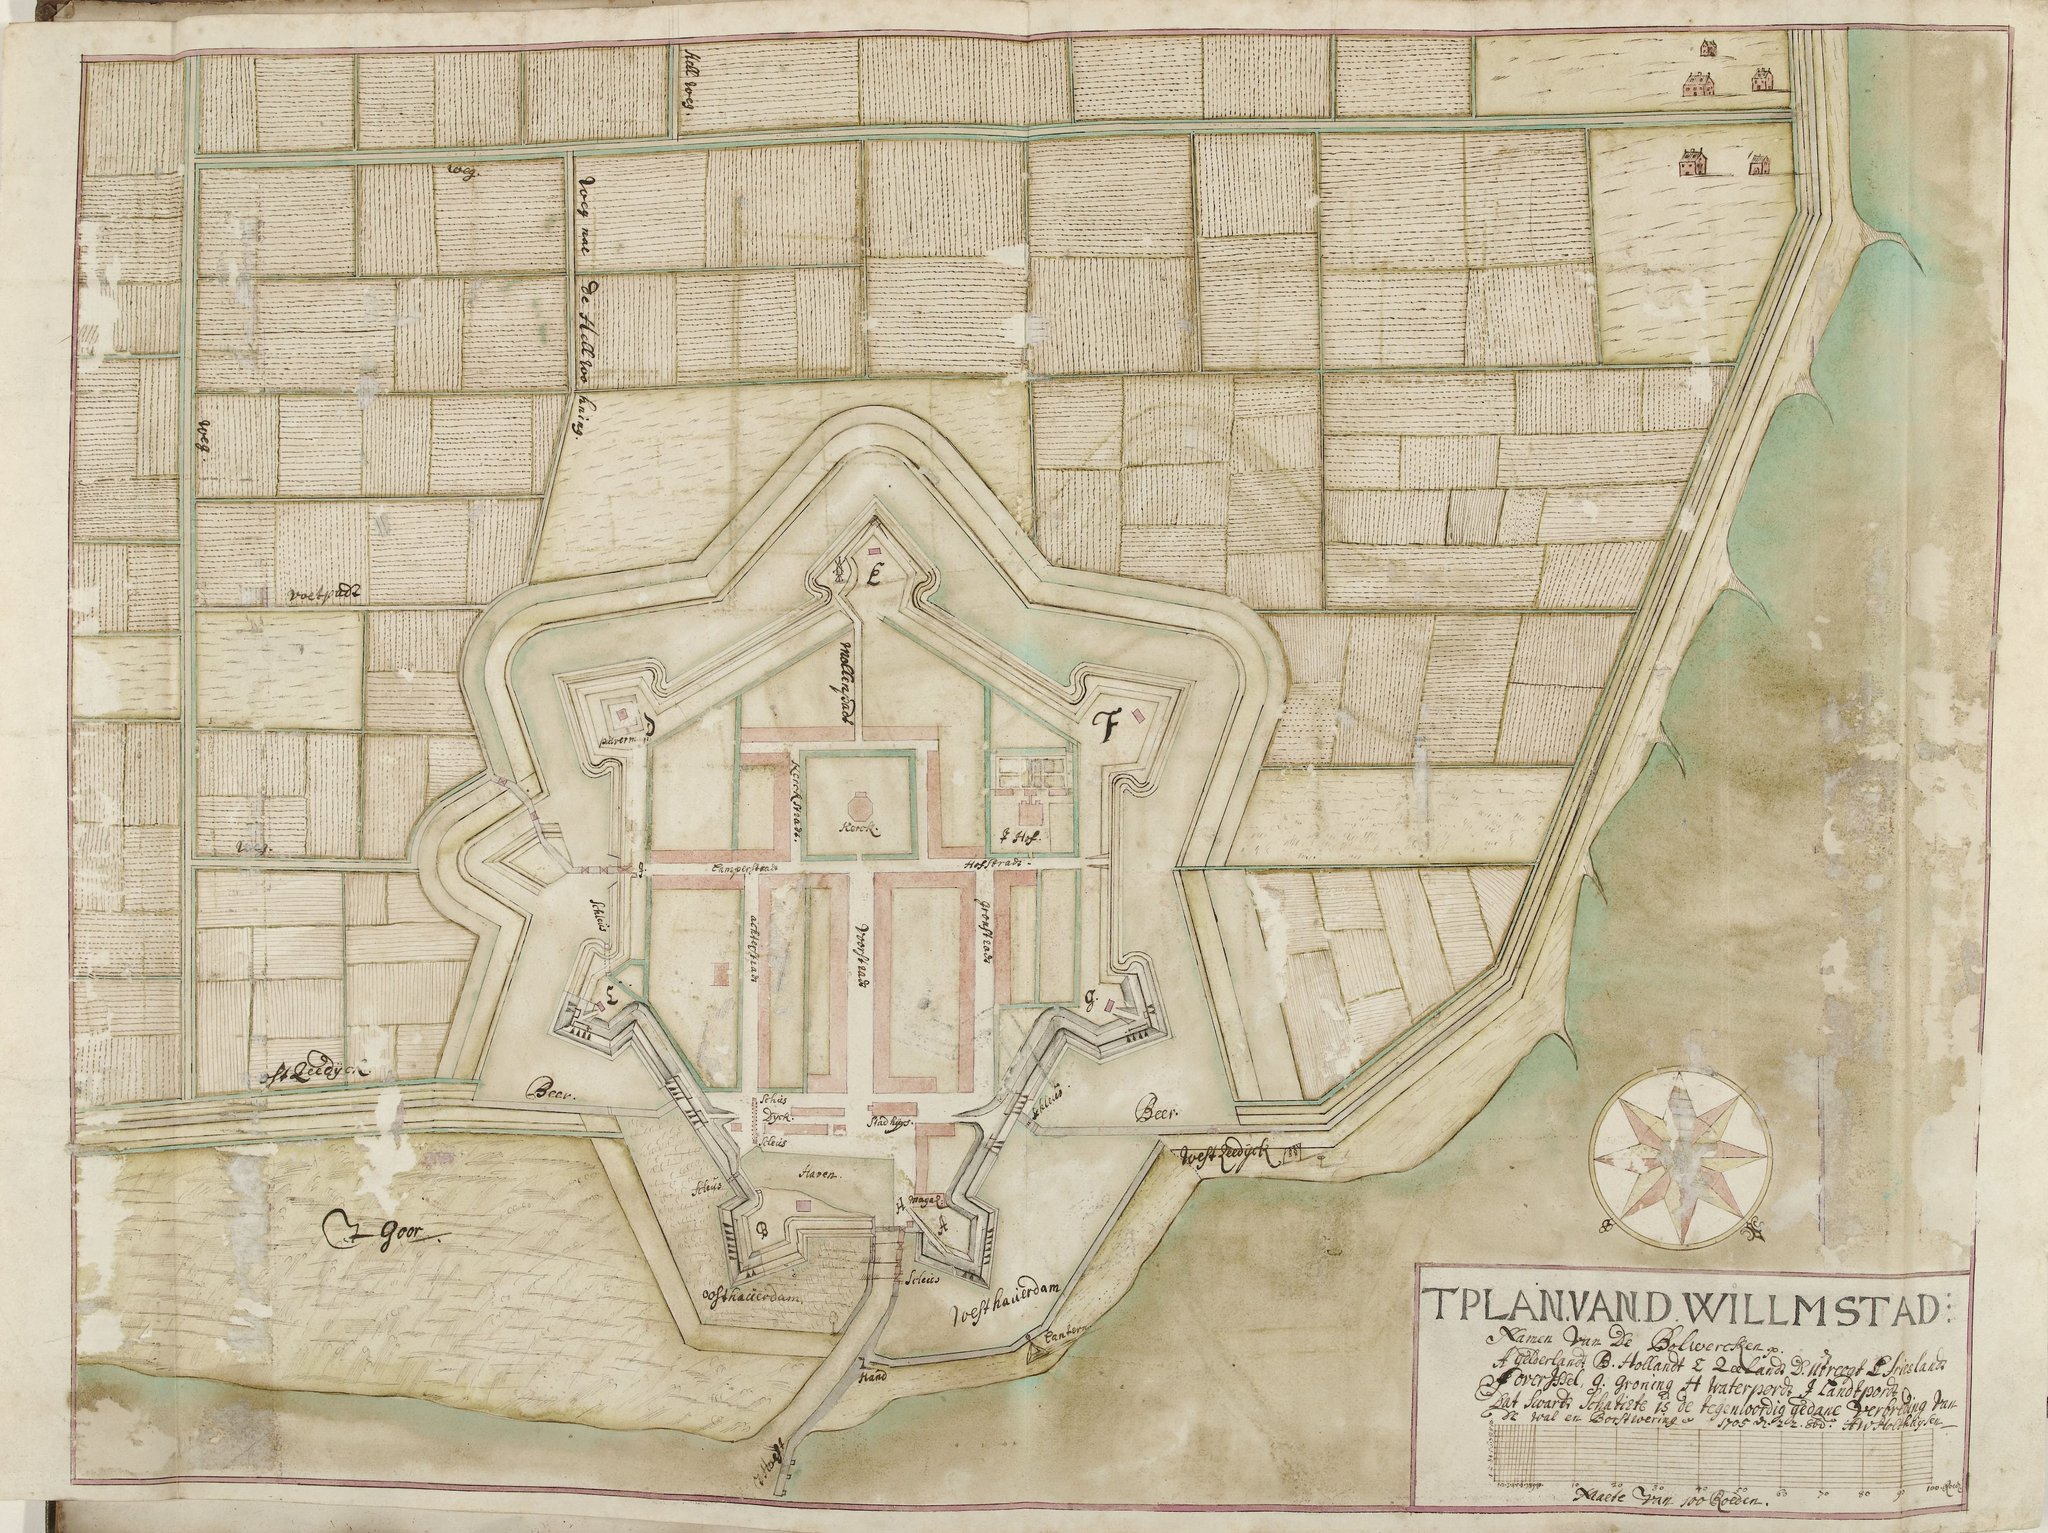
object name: drawing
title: Plattegrond van Willemstad, 1705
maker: arnold willem holthuisen (van)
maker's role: engineer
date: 1705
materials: paper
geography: netherlands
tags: fortress, maps of cities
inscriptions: collector's mark: Lugt 2166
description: Plattegrond van de versterkingen om de stad Willemstad, 1705. Rechtsonder een cartouche met de titel en de legenda A-I in het Nederlands. Onderdeel van een verzameling getekende plannen van versterkte plaatsen in Nederland en omringende landen ten tijde van de Spaanse Successieoorlog (deel C).